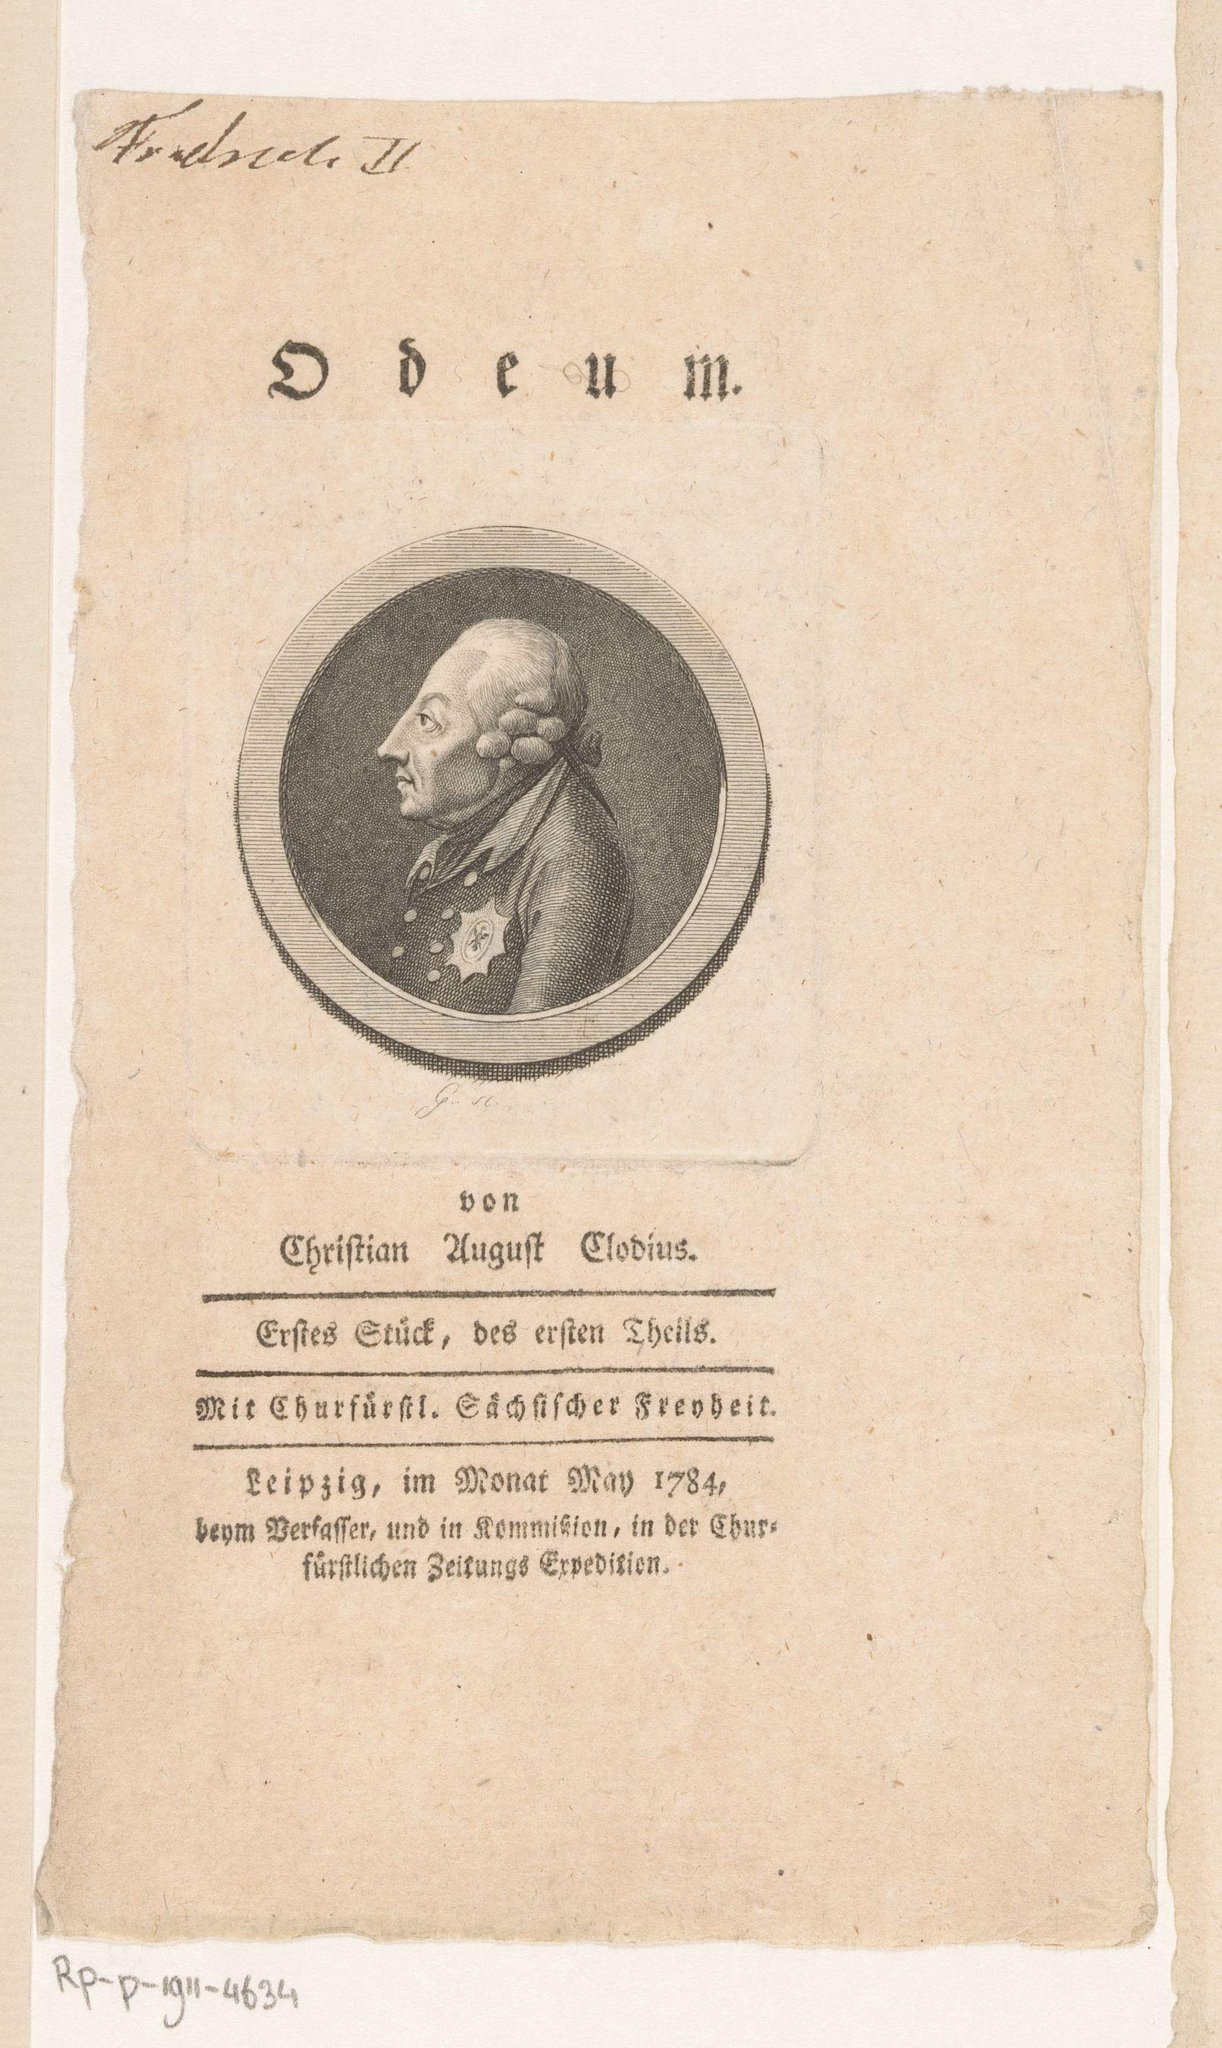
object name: titelblad, titelpagina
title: Titelpagina voor: Christian August Clodius, Odeum, 1784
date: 1784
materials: paper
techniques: engraving, letterpress printing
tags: berlin, frederick ii (king of prussia), knighthood order (with name) - insignia of a knighthood order, e.g.: badge, chain (with name of order), historical persons, emperor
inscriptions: collector's mark: Lugt 2228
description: Prent uit: Clodius, Christian August. Odeum. Leipzig: Christian August Clodius, 1784.